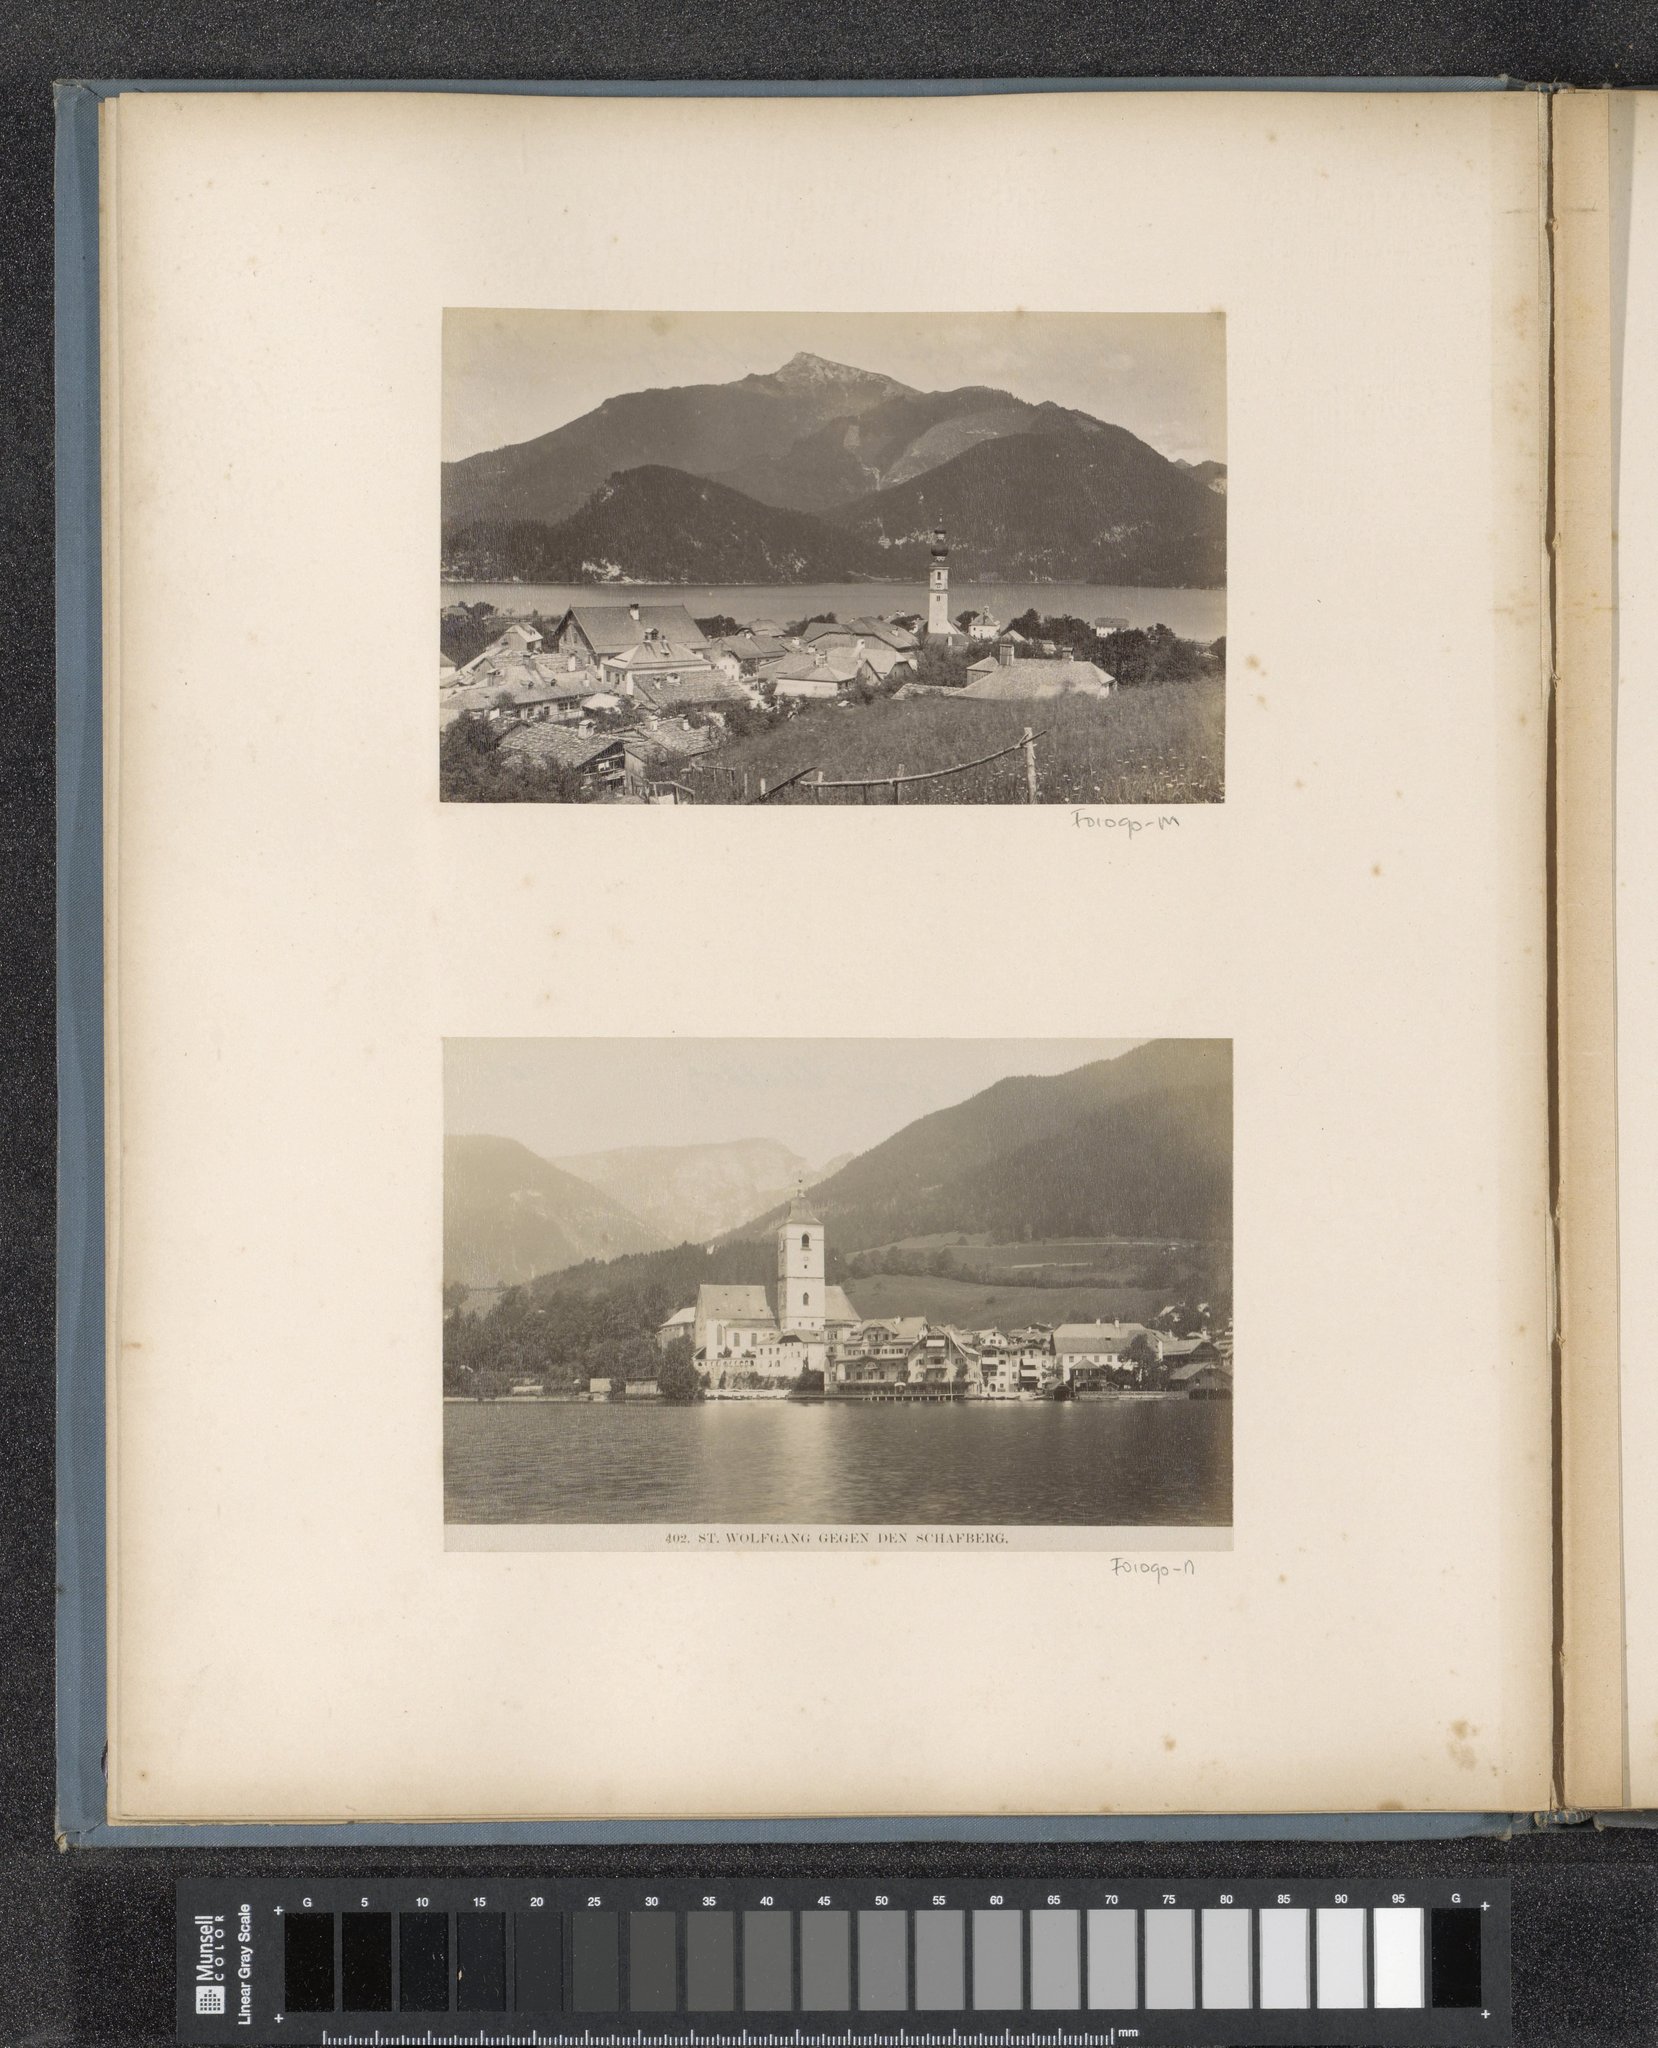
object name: photograph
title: Dorp aan een meer, vermoedelijk in Oostenrijk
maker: Anonymous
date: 1870-1900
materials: paper, photographic support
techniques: albumen print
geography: austria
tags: prospect of village, silhouette of village, austria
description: Onderdeel van Reisalbum met foto's van bezienswaardigheden in Duitsland en Oostenrijk en van kunstwerken.